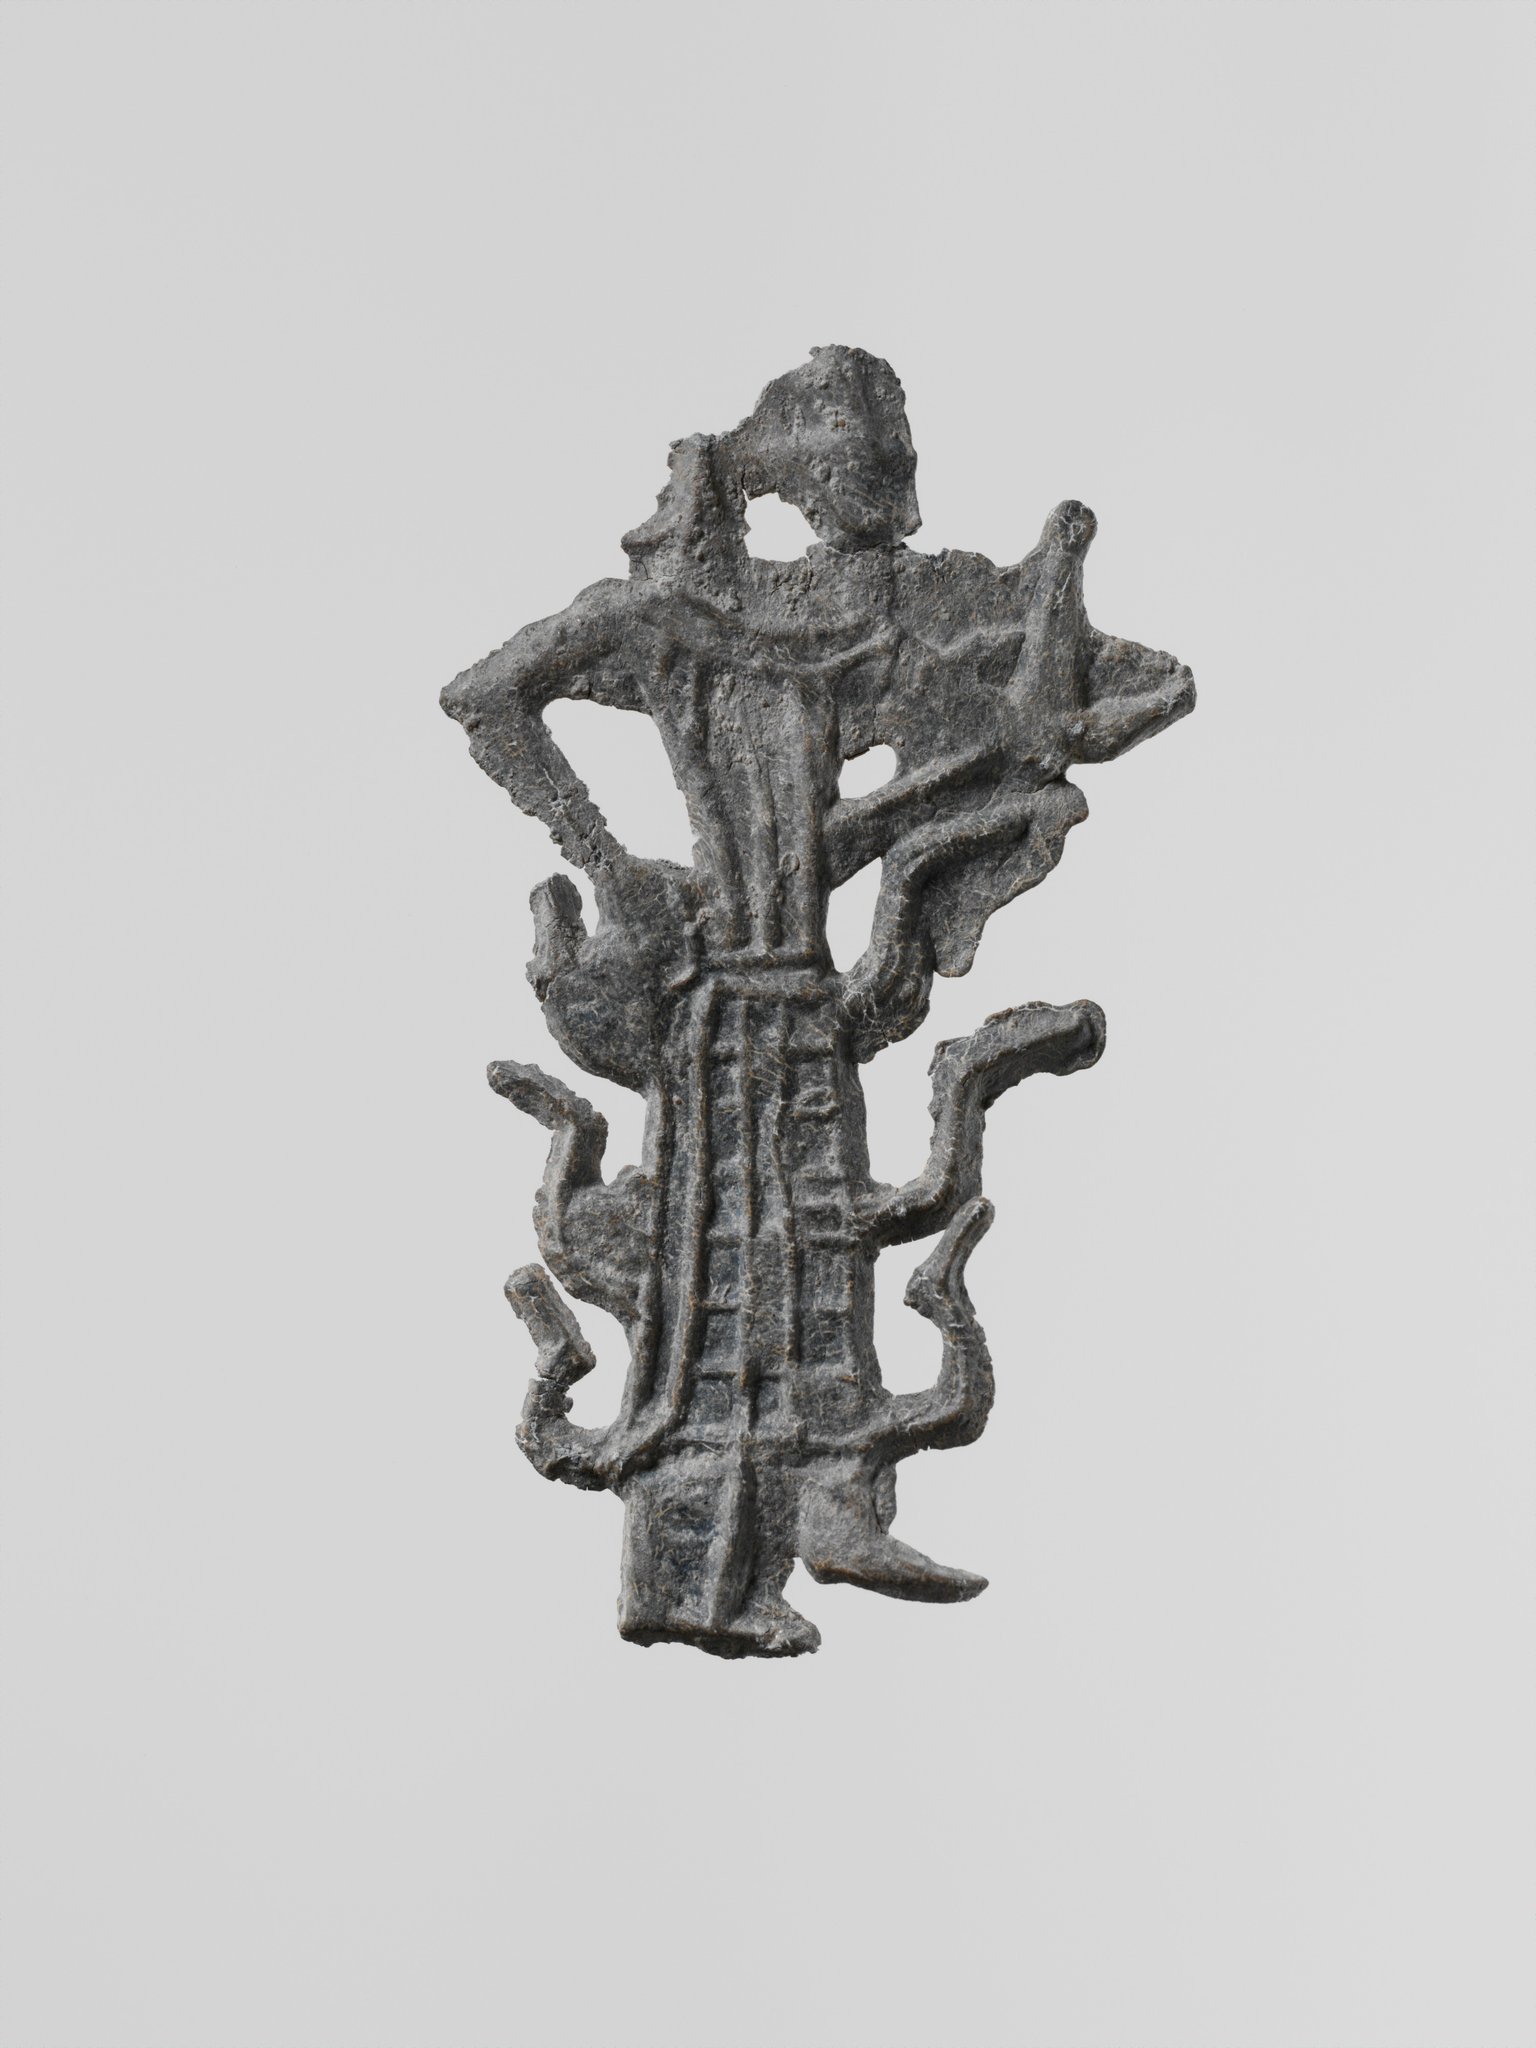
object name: statuette of athena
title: Lead figure of a goddess with an aegis, probably Athena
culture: greek, laconian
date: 600-401 BCE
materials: lead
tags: athena